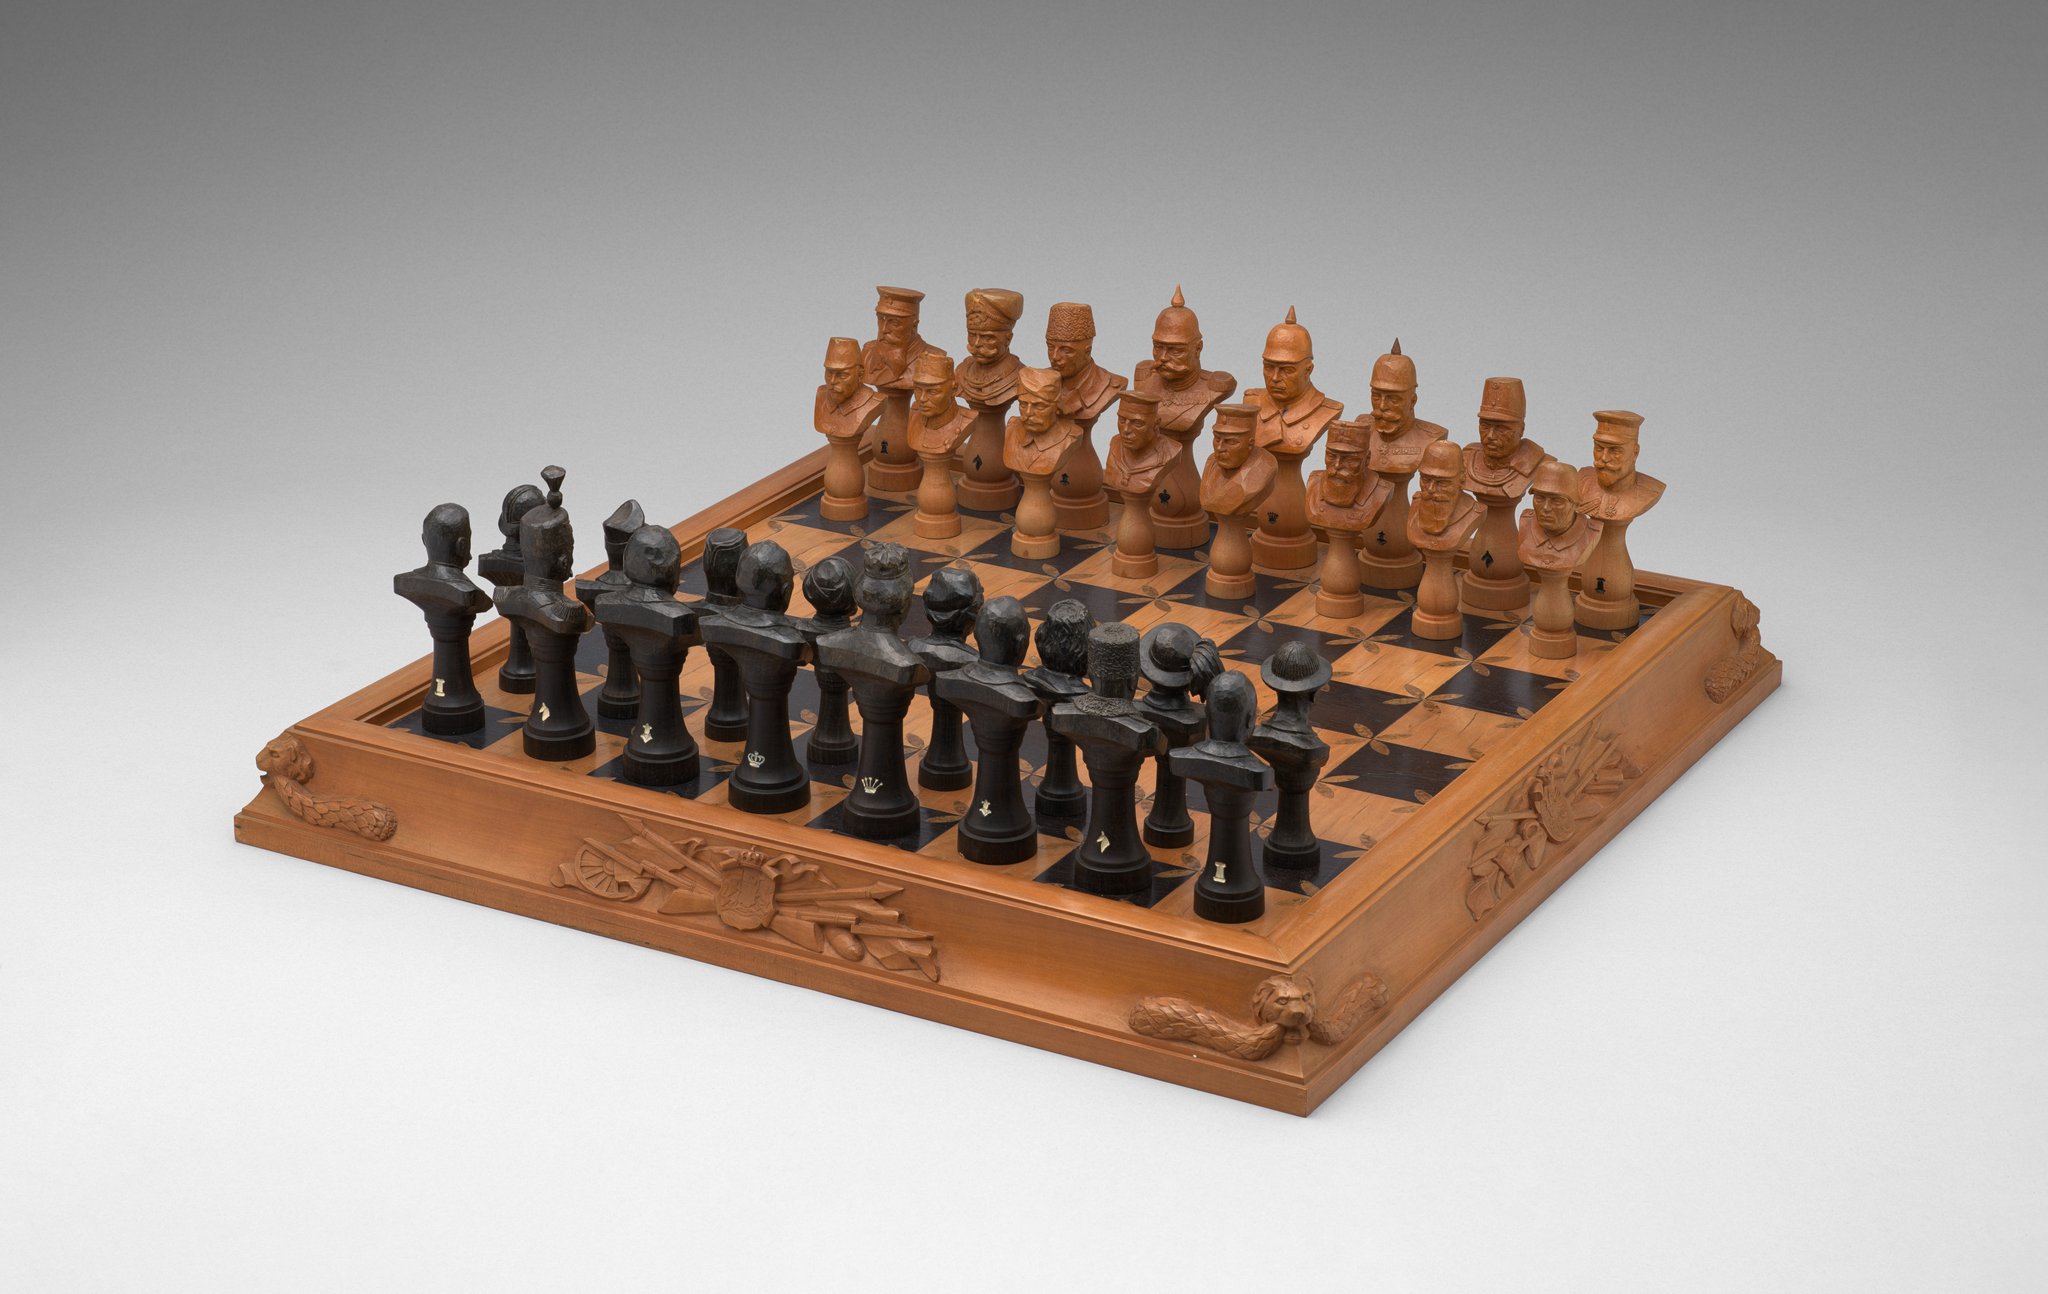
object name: chess set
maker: max nicholas niemeier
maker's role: maker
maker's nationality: german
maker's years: 1876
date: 1917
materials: wood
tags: chess